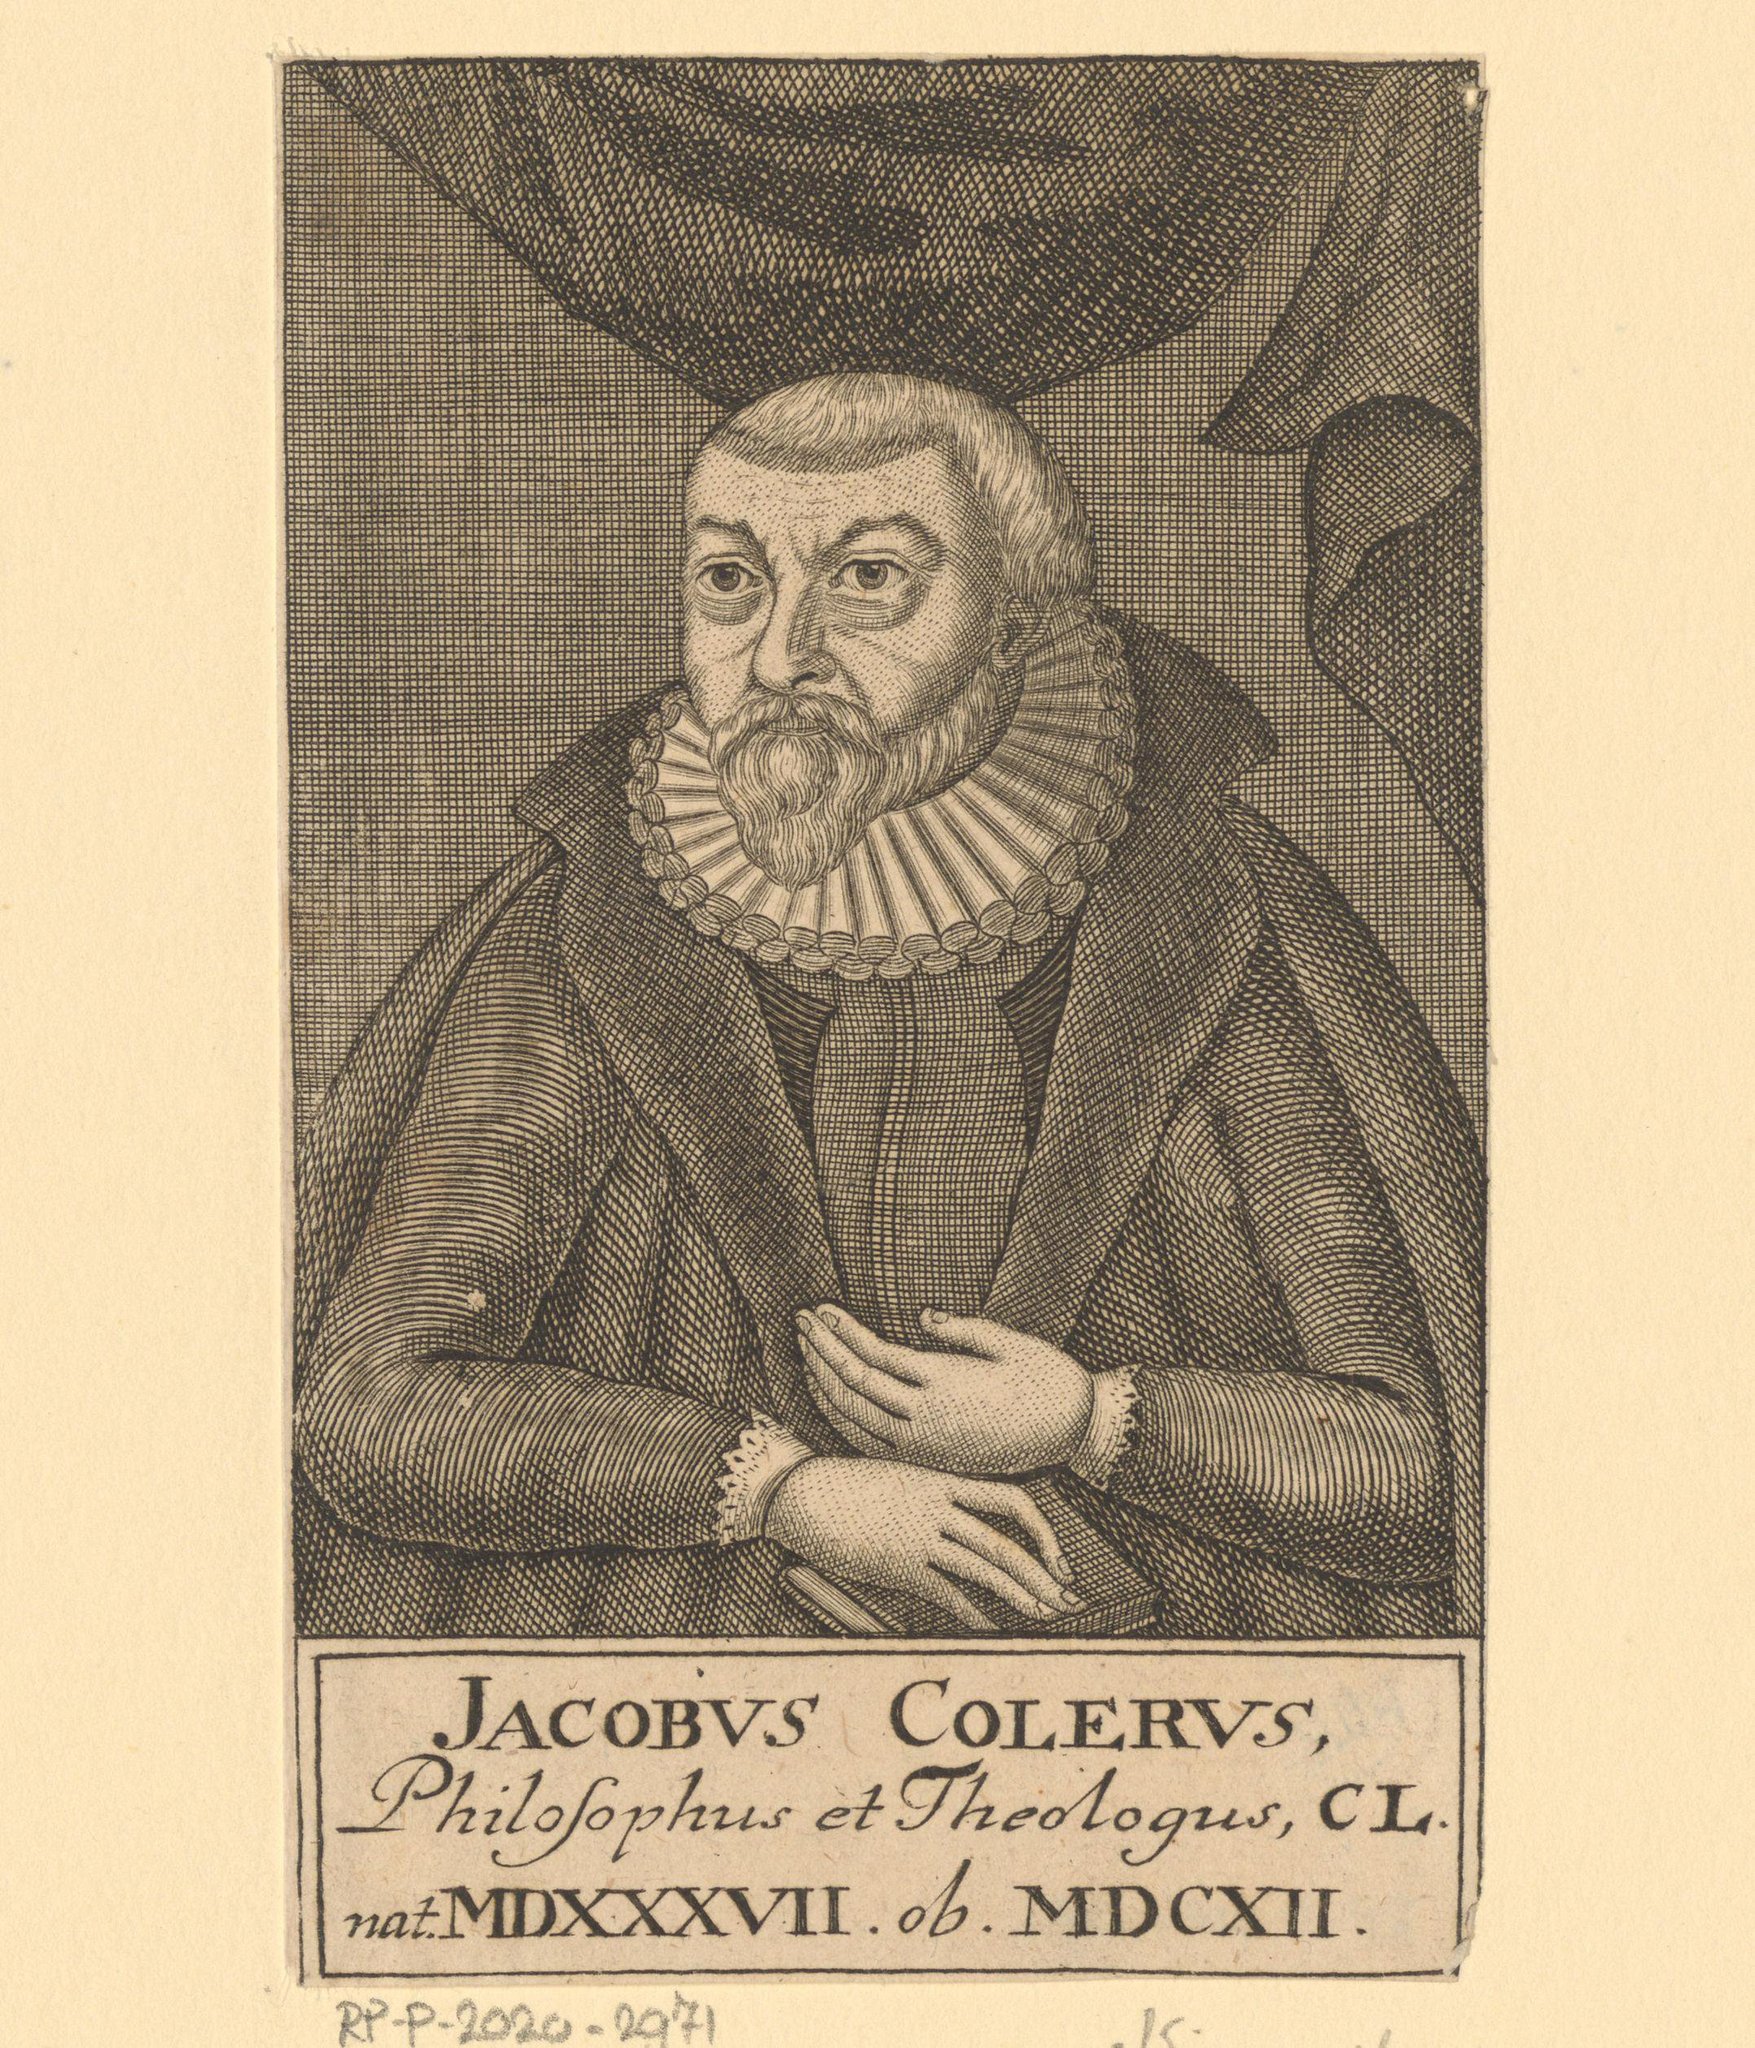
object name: print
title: Portret van Jacob Coler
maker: wolfgang philipp kilian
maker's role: artist, draughtsman, print maker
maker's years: 1654-1732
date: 1723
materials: paper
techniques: engraving, etching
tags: historical persons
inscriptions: collector's mark: Lugt 1388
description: Prent mogelijk uit: Fortgesetzte Sammlung von Alten und Neuen Theologischen Sachen (...). Leipzig: erven Johann Friedrich Brauns, 1723.